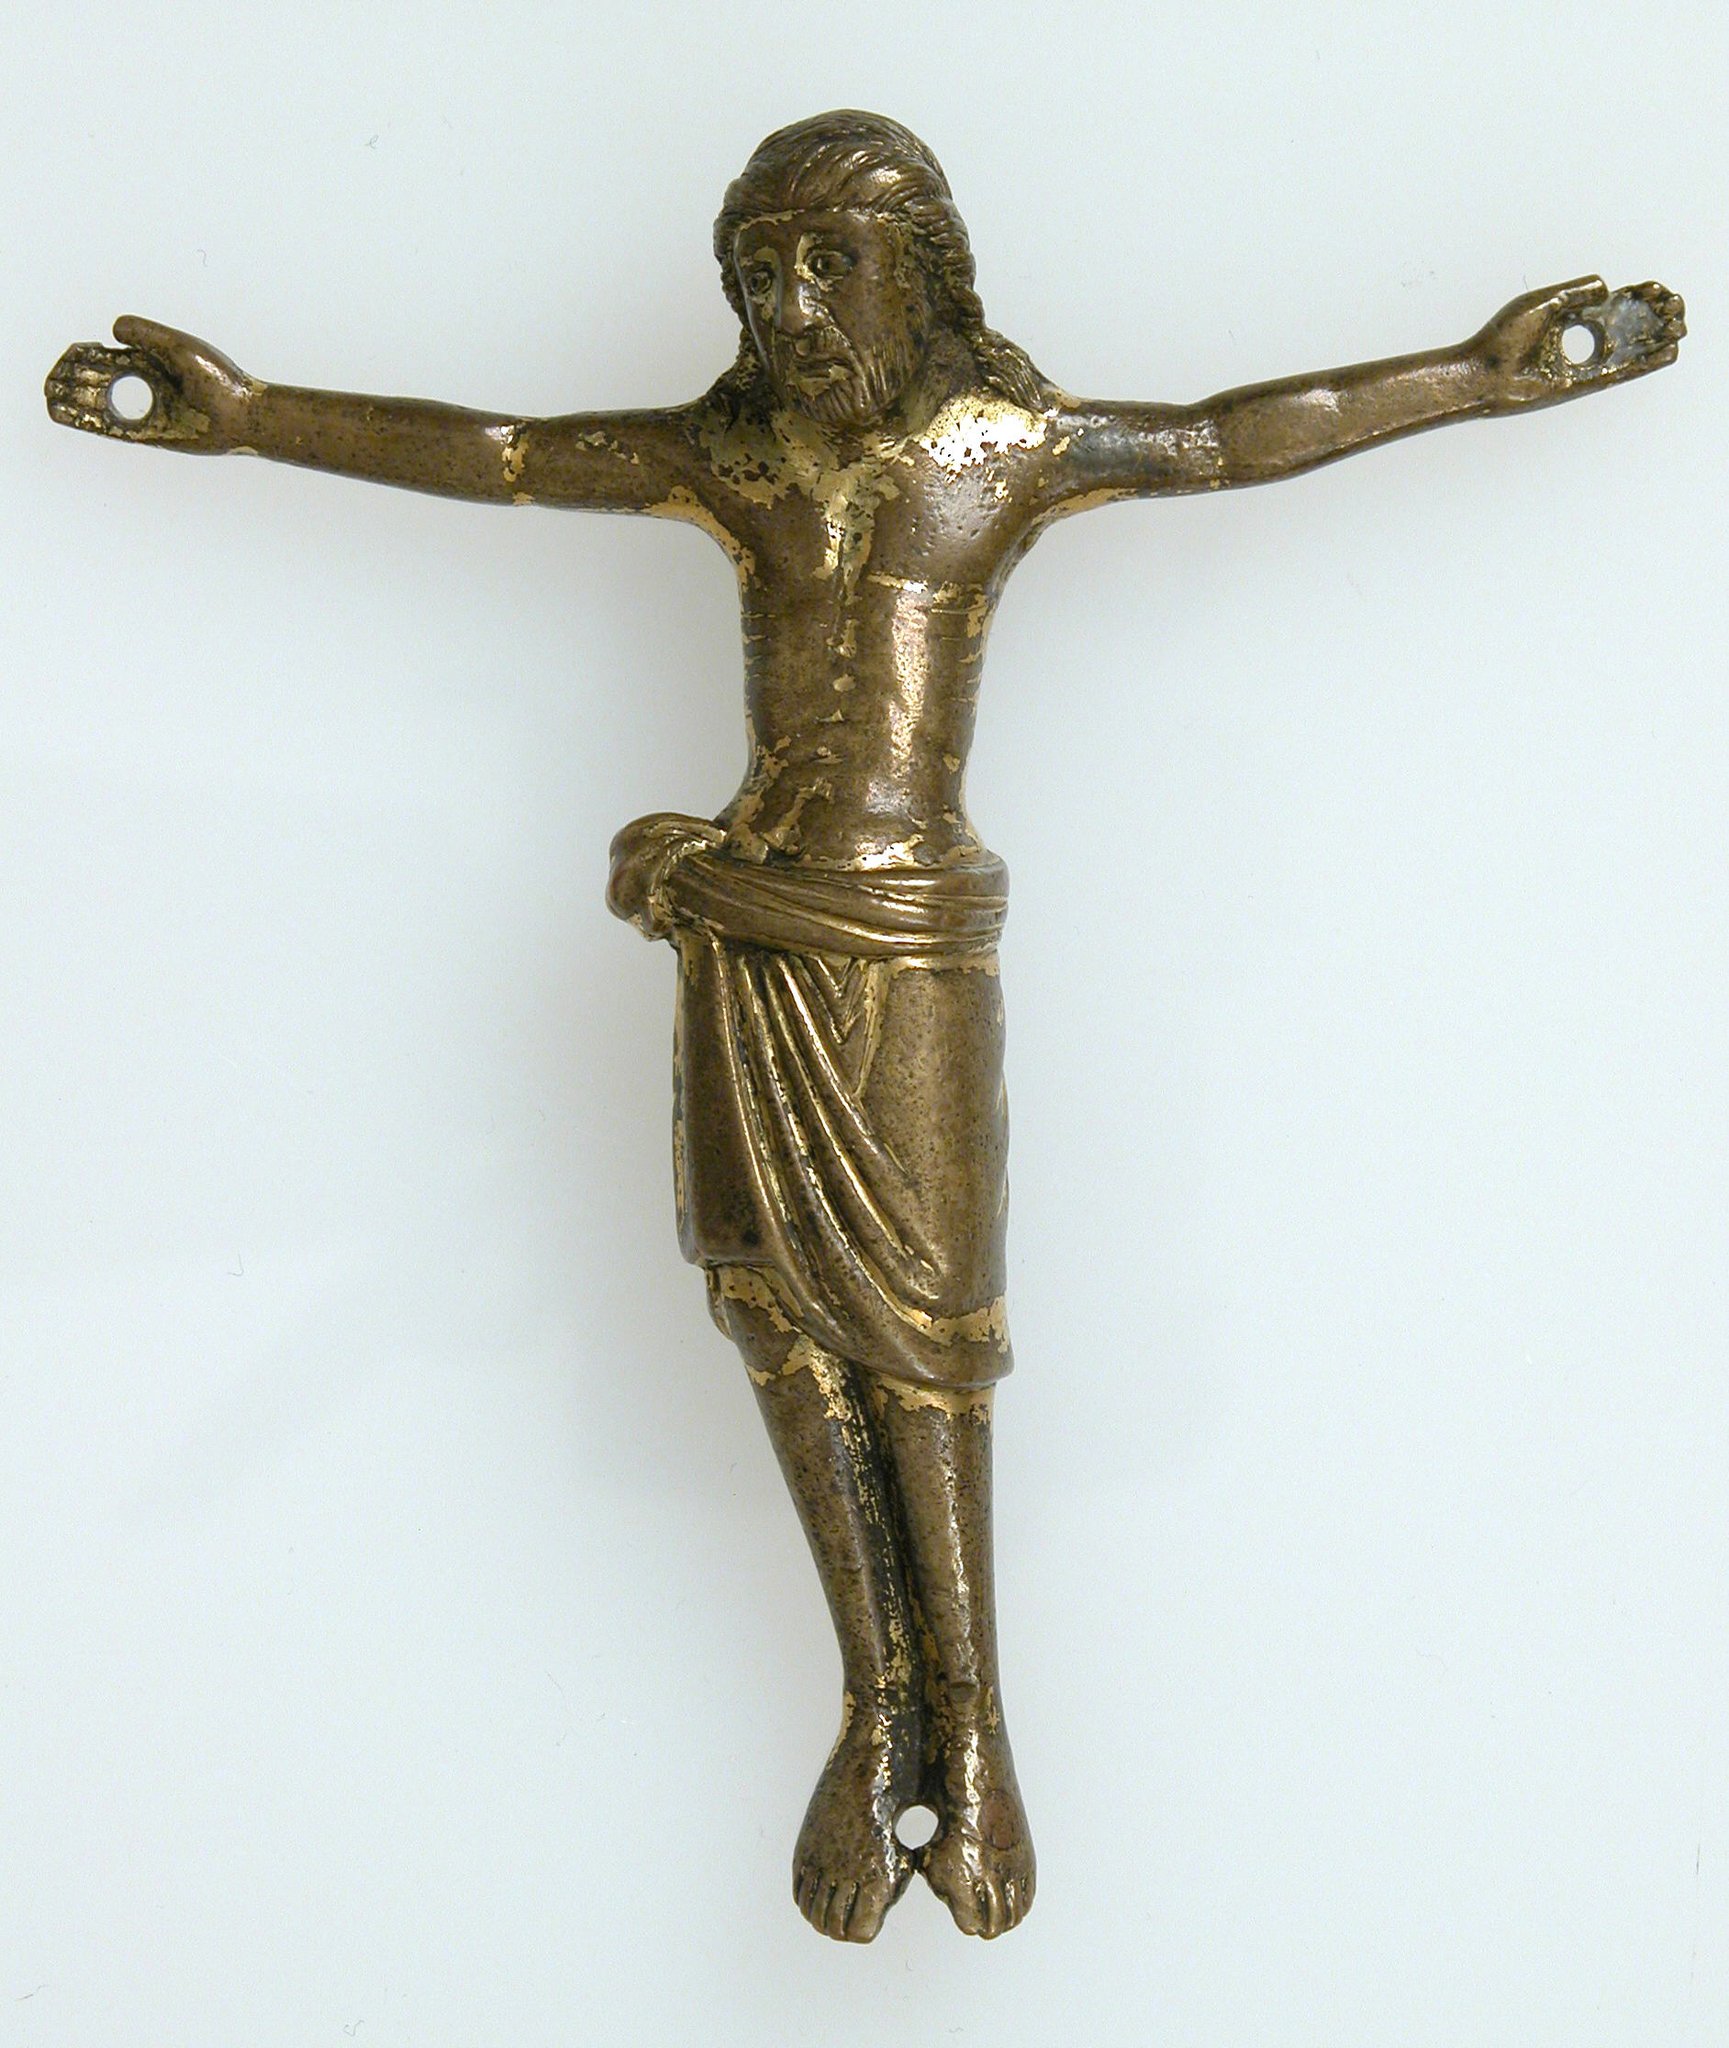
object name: corpus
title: Crucified Christ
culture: south netherlandish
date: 1160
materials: copper alloy, gilt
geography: netherlands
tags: christ